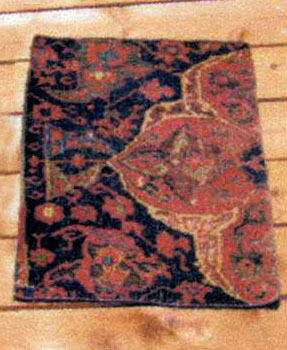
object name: carpet fragment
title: Ushak Carpet Fragment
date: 1667-1733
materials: wool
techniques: pile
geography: turkey